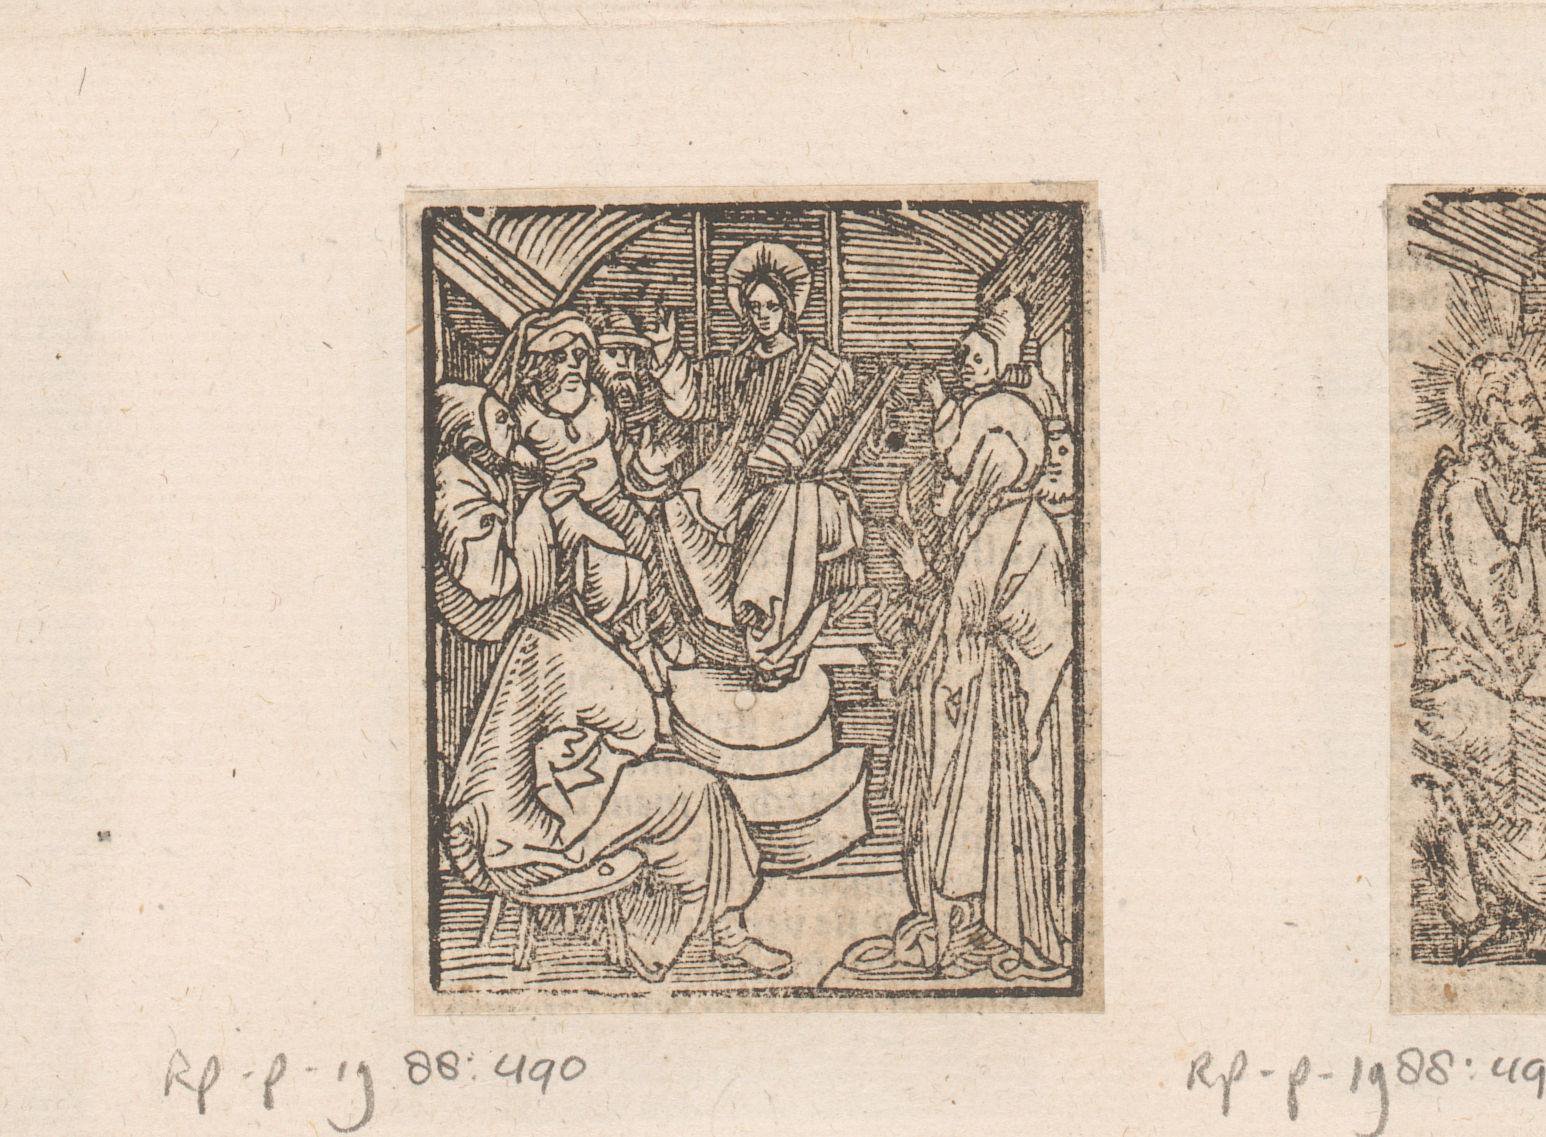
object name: print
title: Christus als twaalfjarige in de tempel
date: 1536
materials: paper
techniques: woodcut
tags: story of the twelve years old christ in jerusalem (luke 2:41-52)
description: Prent afkomstig uit: Evangelia und Epistel. Neurenberg: Hans Guldenmund, 1536.